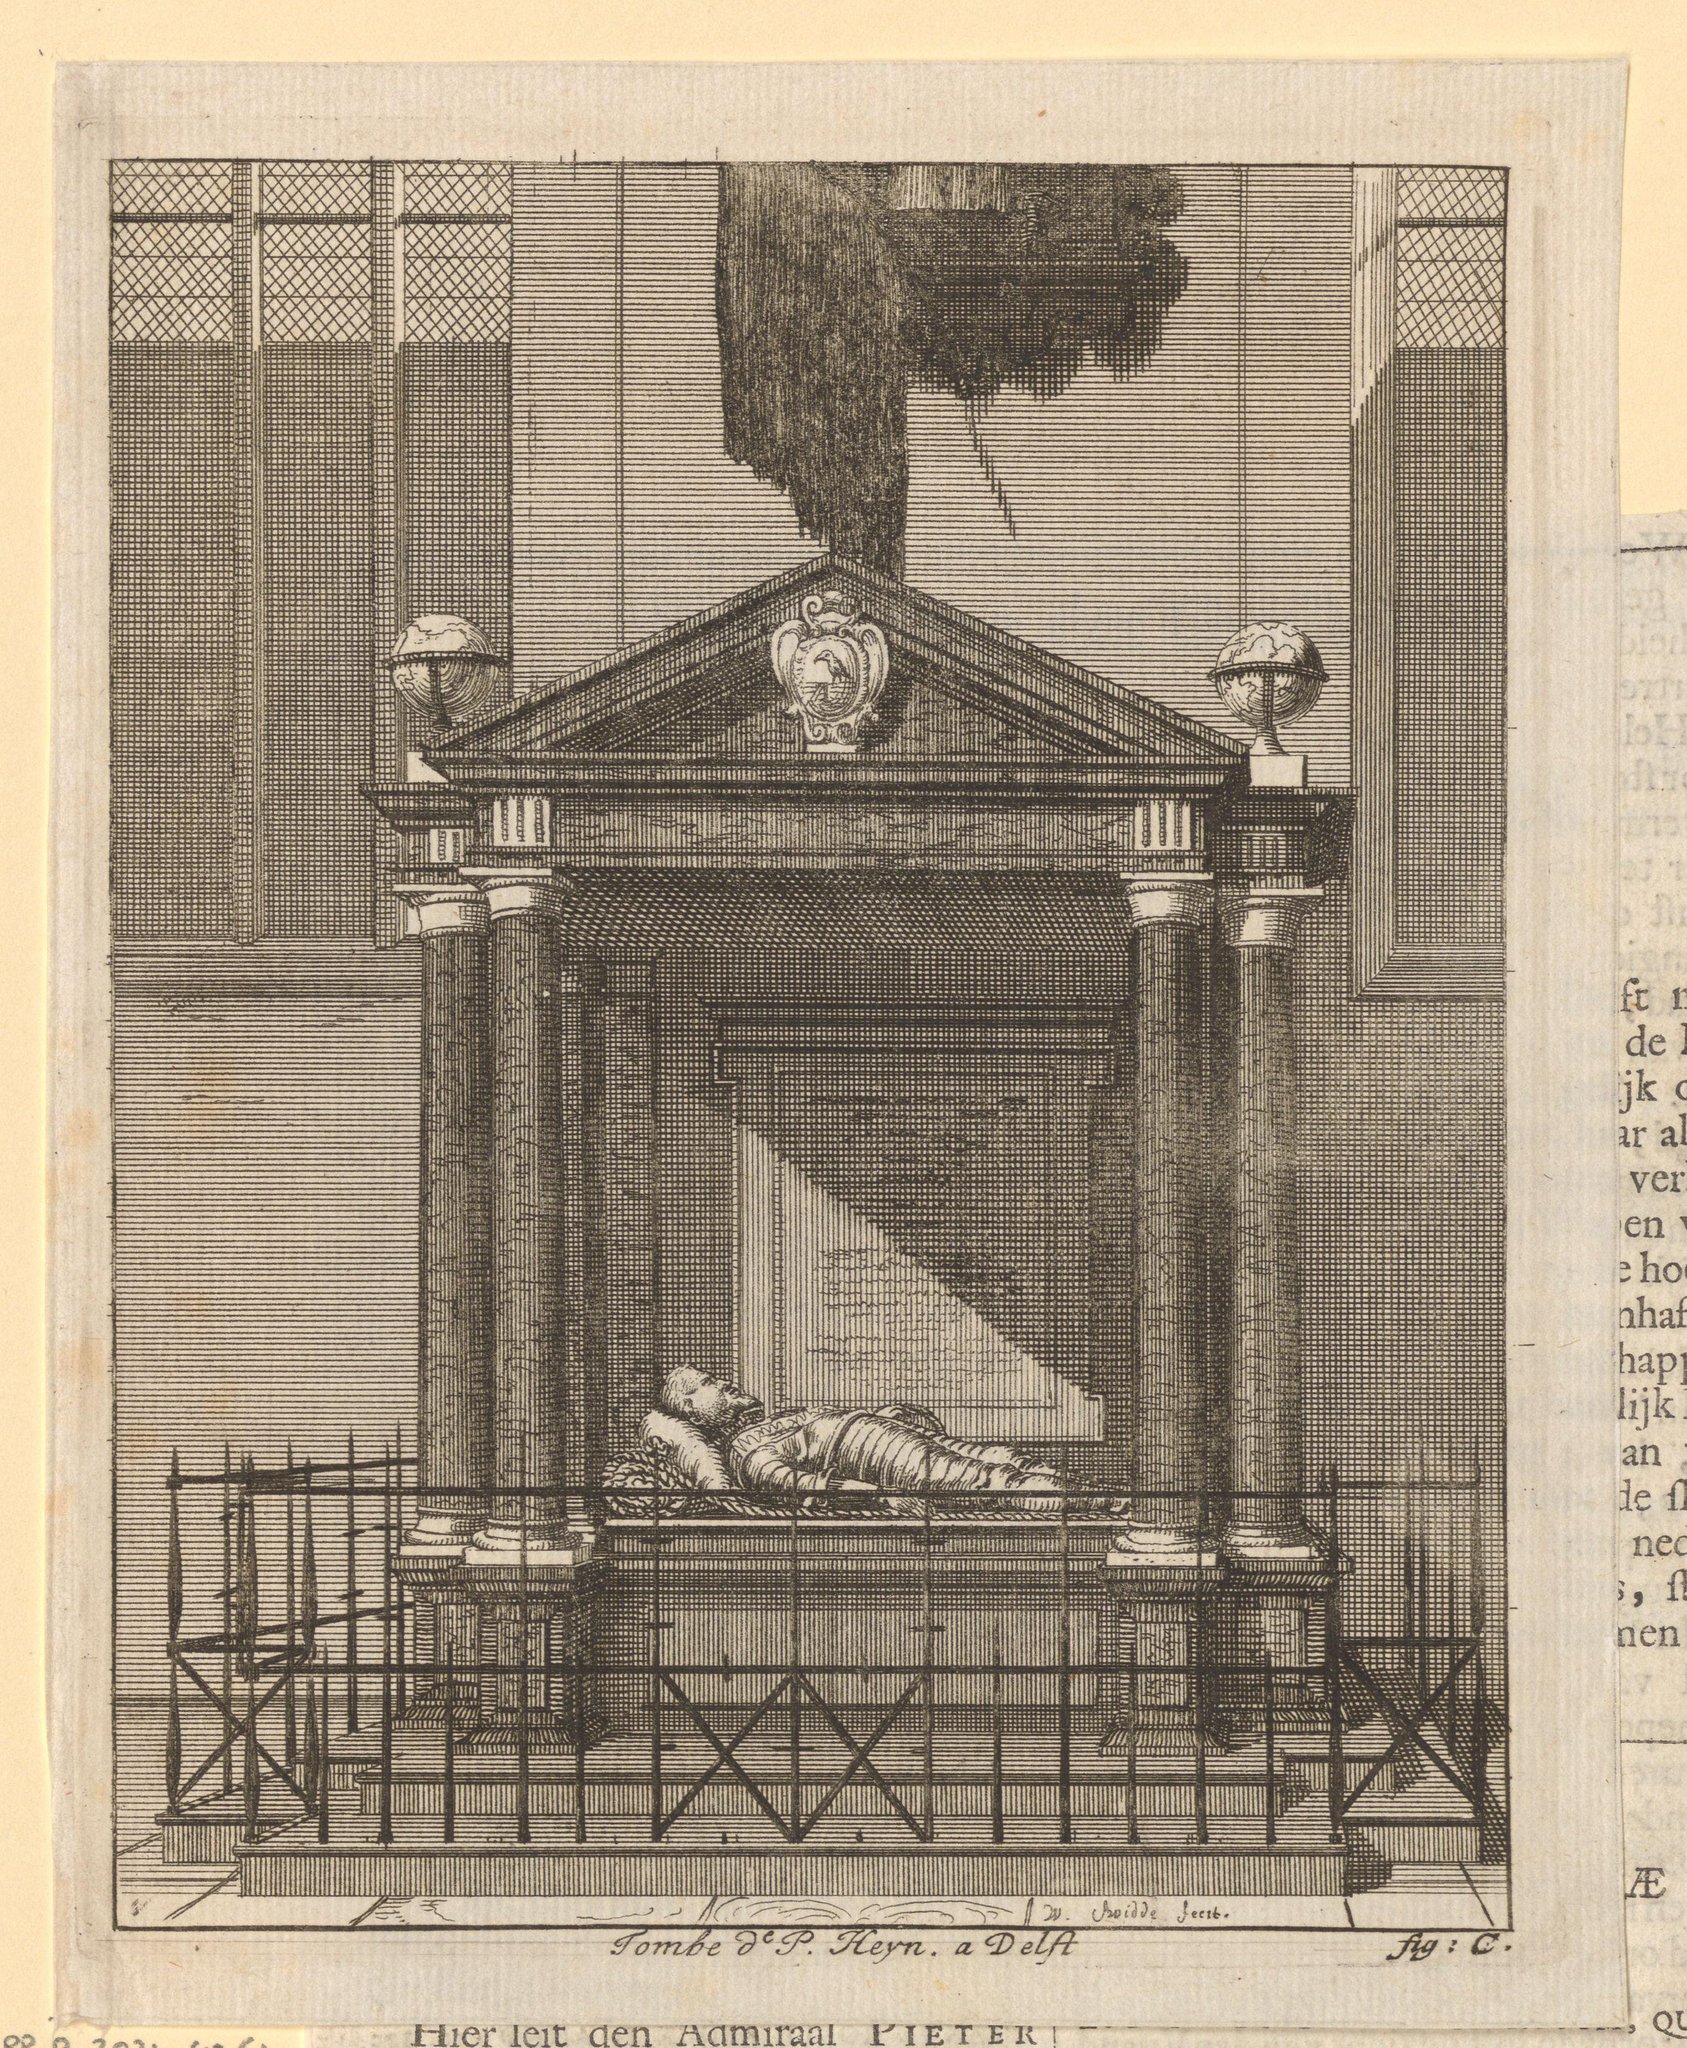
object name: print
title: Grafmonument van Piet Hein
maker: willem swidde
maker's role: print maker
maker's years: 1660-1697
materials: paper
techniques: etching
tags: delfshaven, historical persons, grave-building, monumental tomb, commander-in-chief, admiral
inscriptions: collector's mark: Lugt 2228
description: Prent waarschijnlijk uit: Nederlands helden-tooneel, vertoonende zeer cierlijk in koper gesneeden alle de grafsteden, (...). S.l.s.n.s.a.